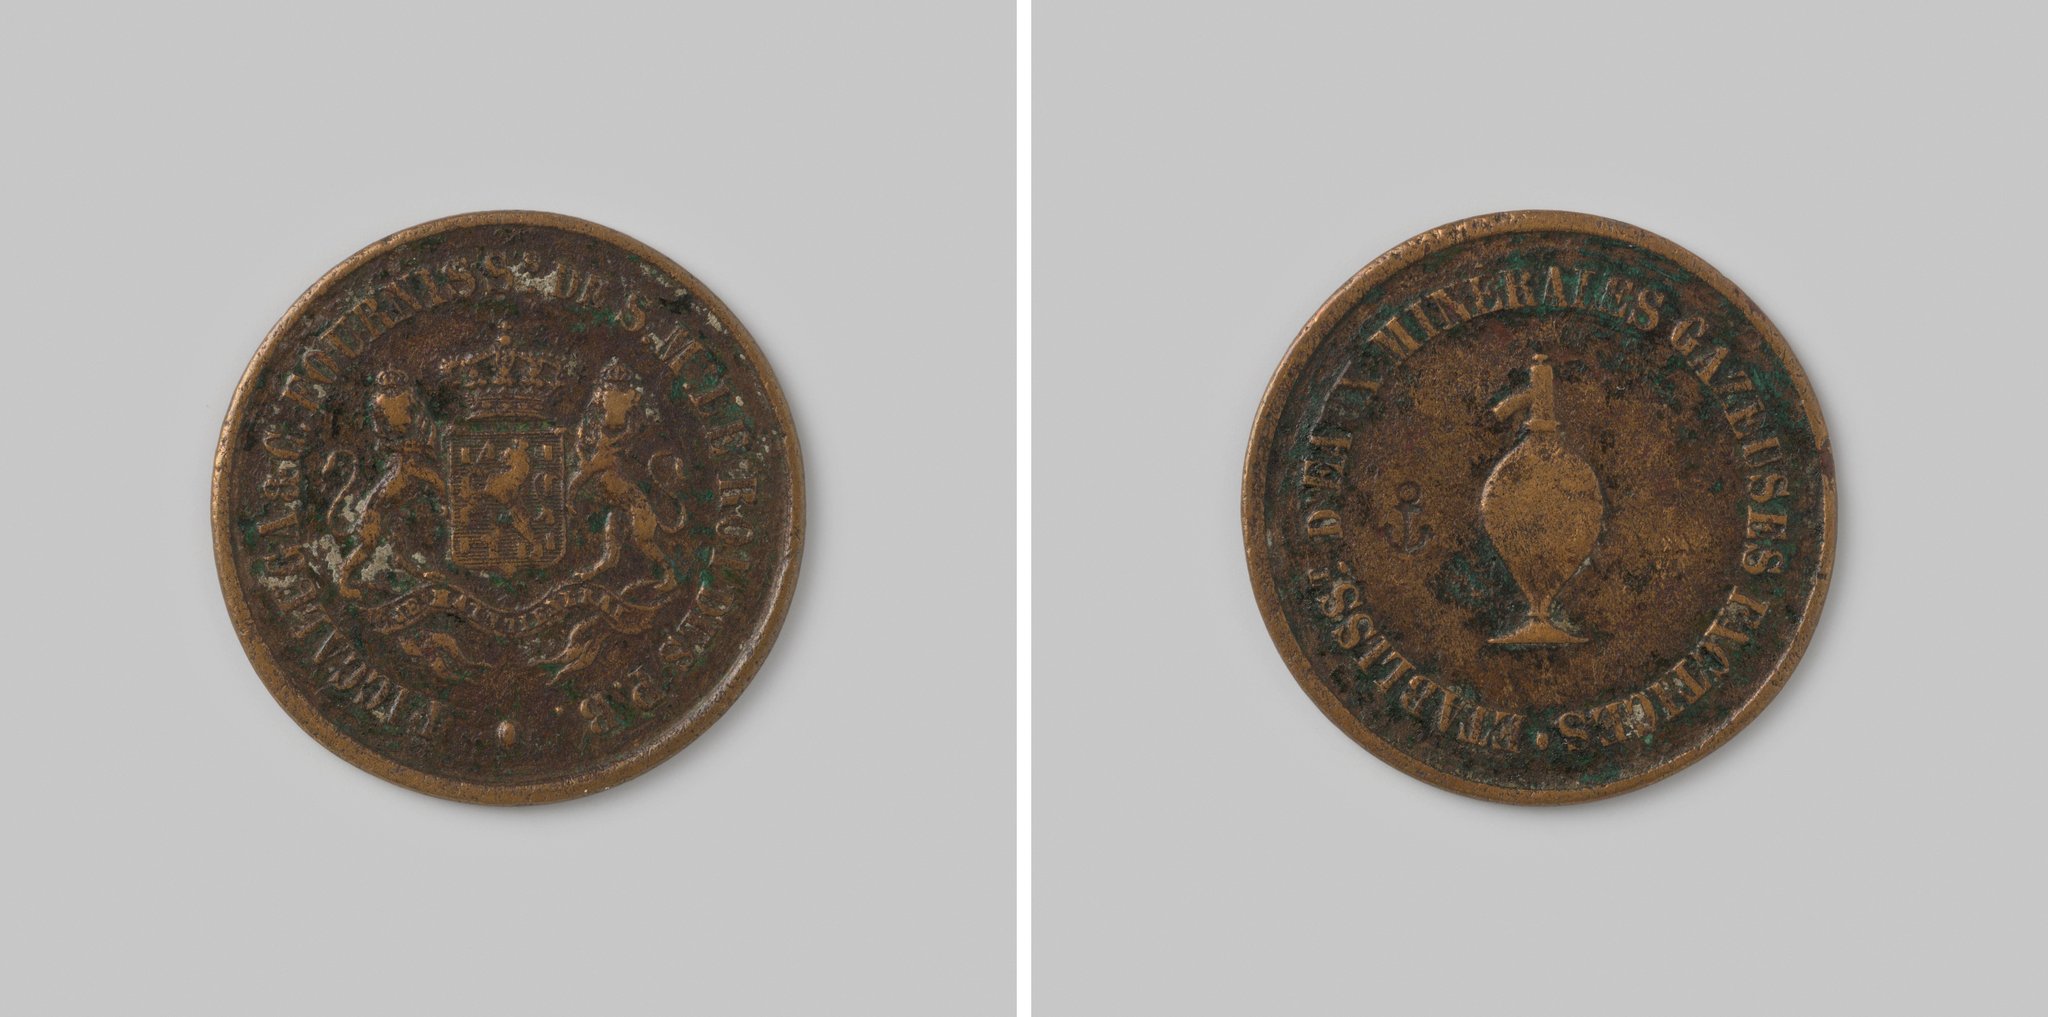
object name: history medal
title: Reclamepenning van de spuitwaterfrabriek Piccaluga en Co,, hofleverancier in Nederland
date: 1870-1890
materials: copper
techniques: striking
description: Koperen penning, op de voorzijde het gekroonde Nederlandse wapenschild met dragers, met omschrift, op de keerzijde een spuitwaterfles met omschrift.